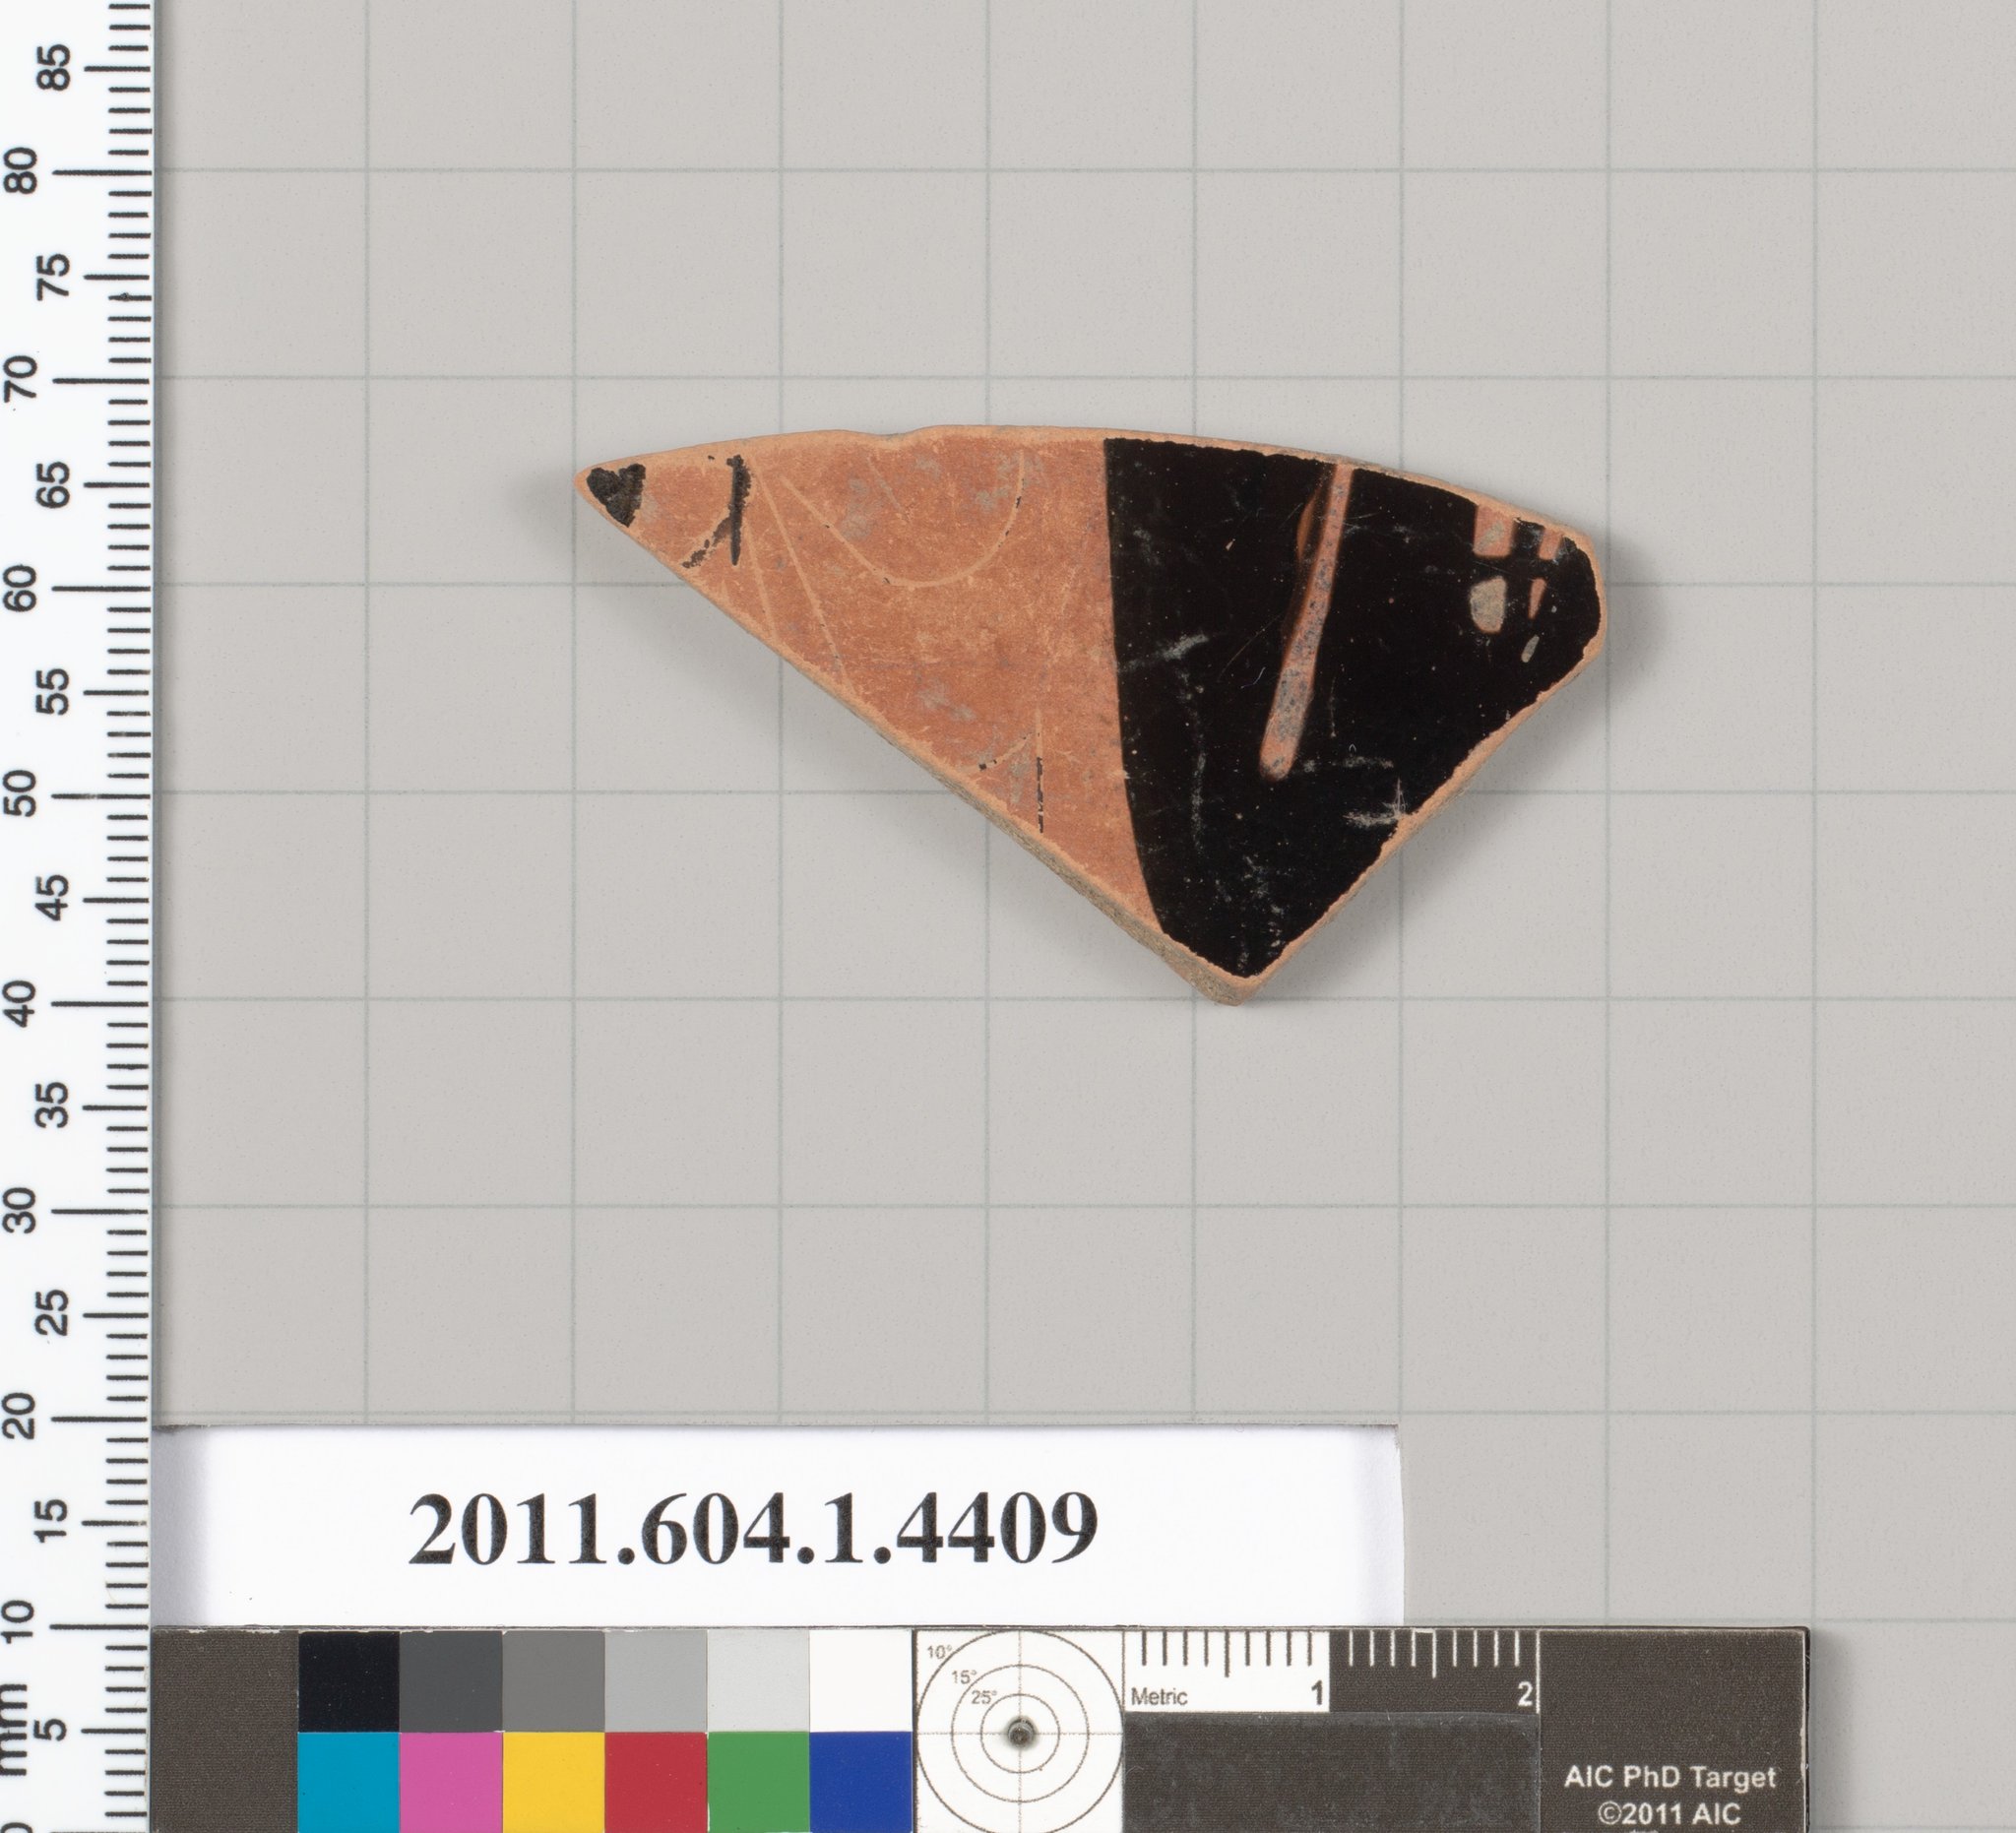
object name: kylix fragment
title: Terracotta fragment of a kylix (drinking cup)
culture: greek, attic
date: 475-451 BCE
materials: terracotta